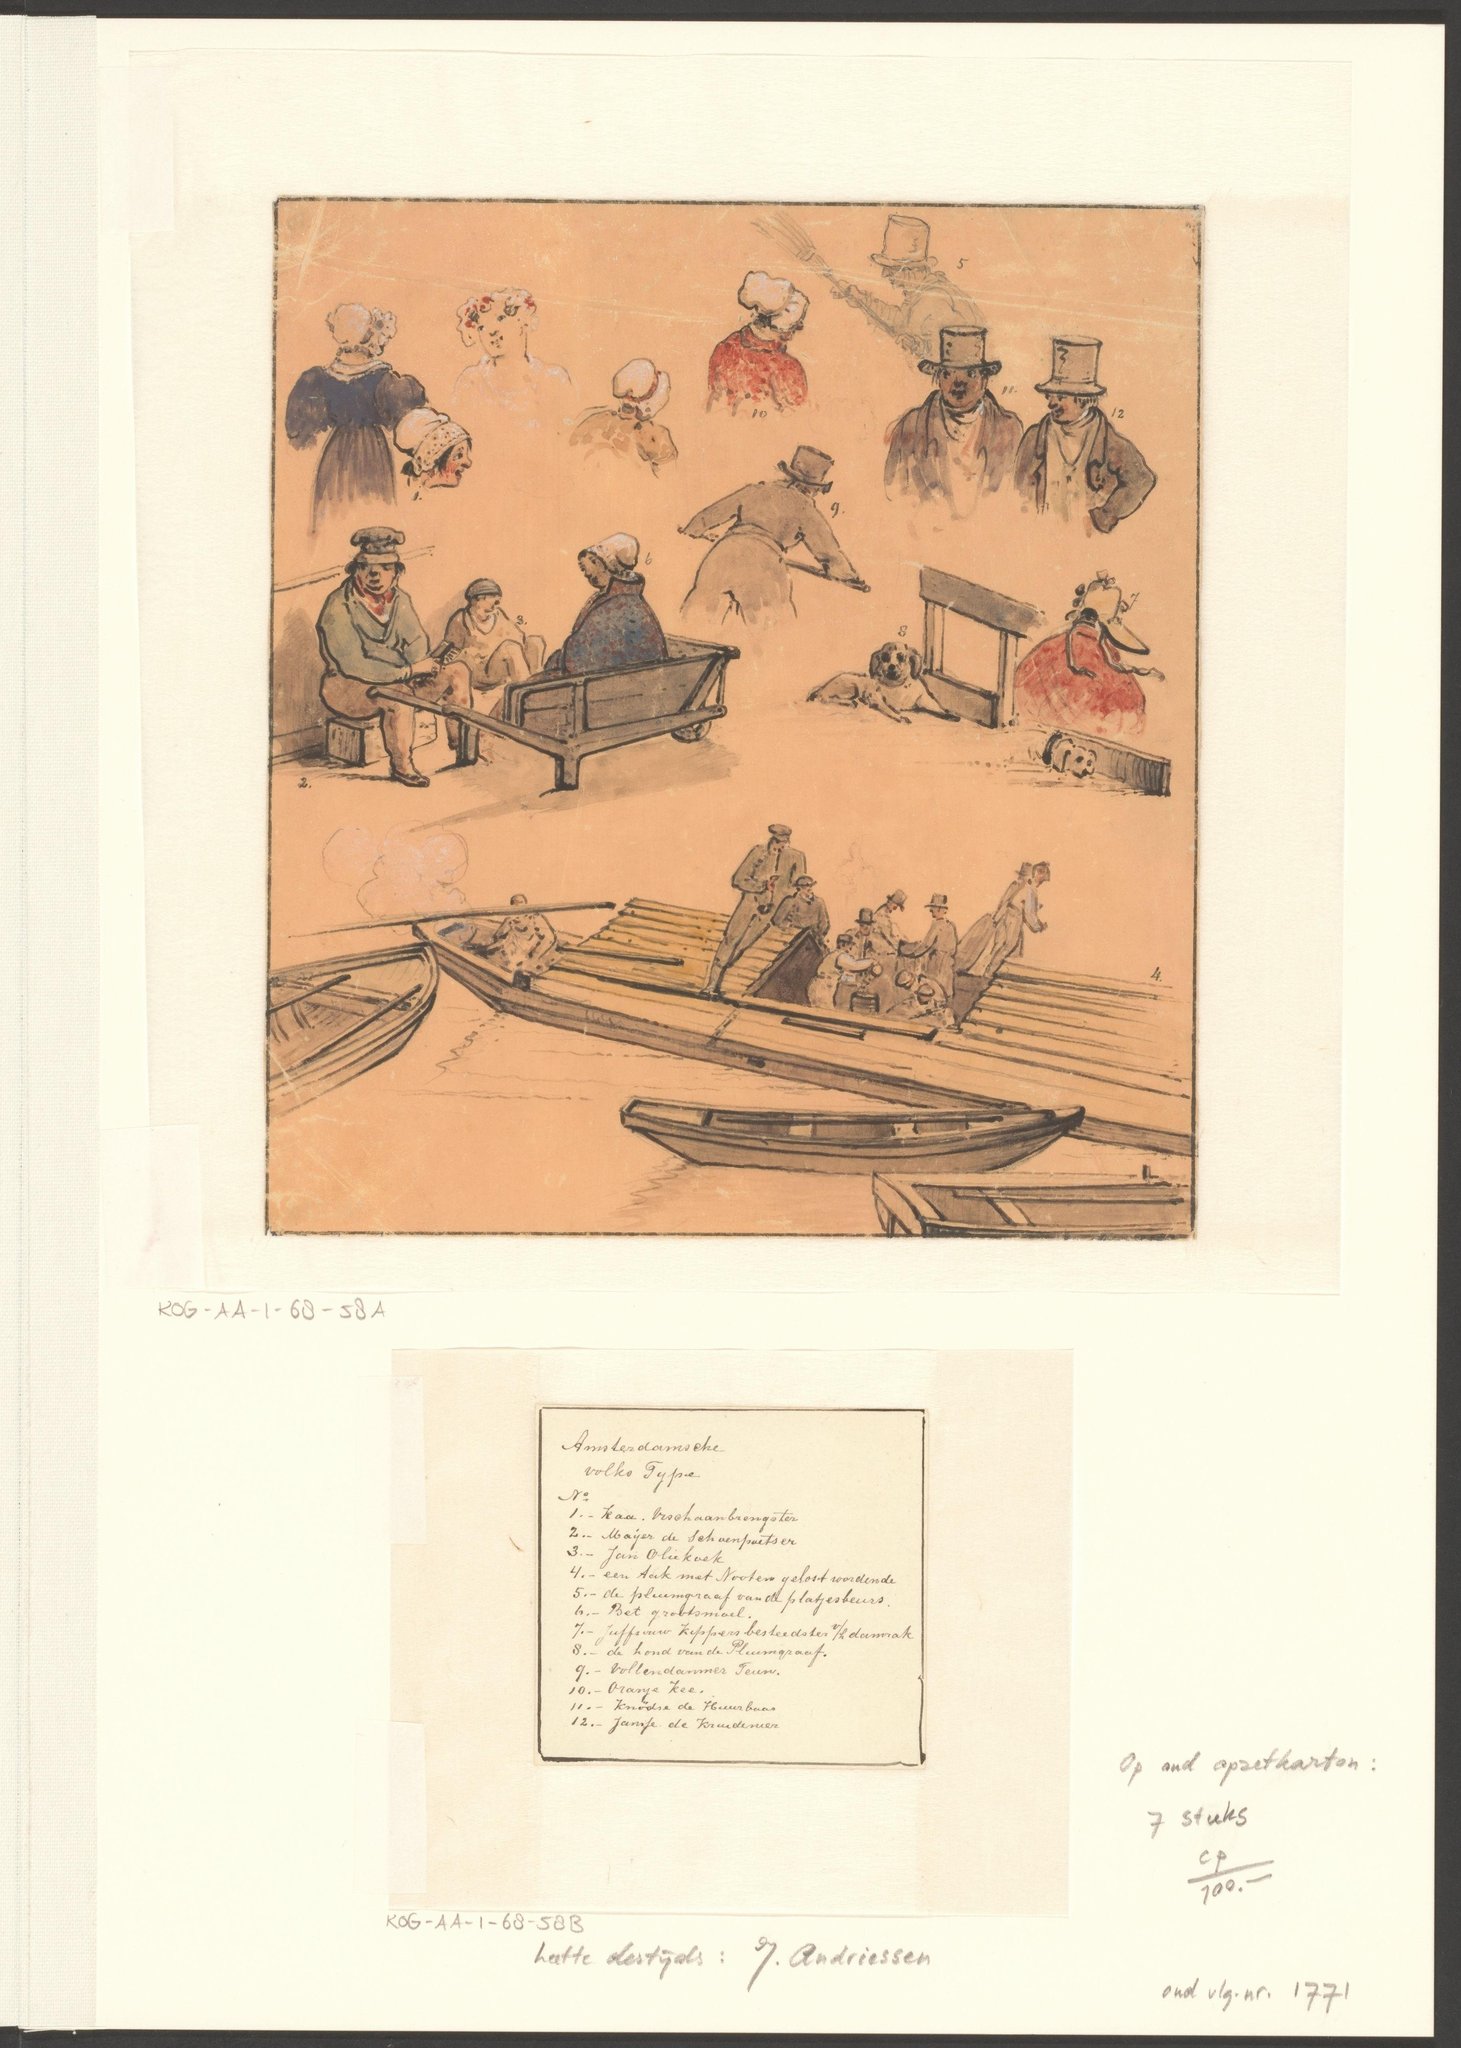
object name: text sheet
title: Legenda behorende bij compositie met Amsterdamse volkstypen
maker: christiaan andriessen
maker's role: draughtsman, print maker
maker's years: 1775-1846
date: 1785-1846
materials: ink, paper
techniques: pen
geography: amsterdam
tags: handwriting, written text, amsterdam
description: Onderwerpsrubriek binnen de Atlas Amsterdam: Amsterdamsche Typen AB - A.